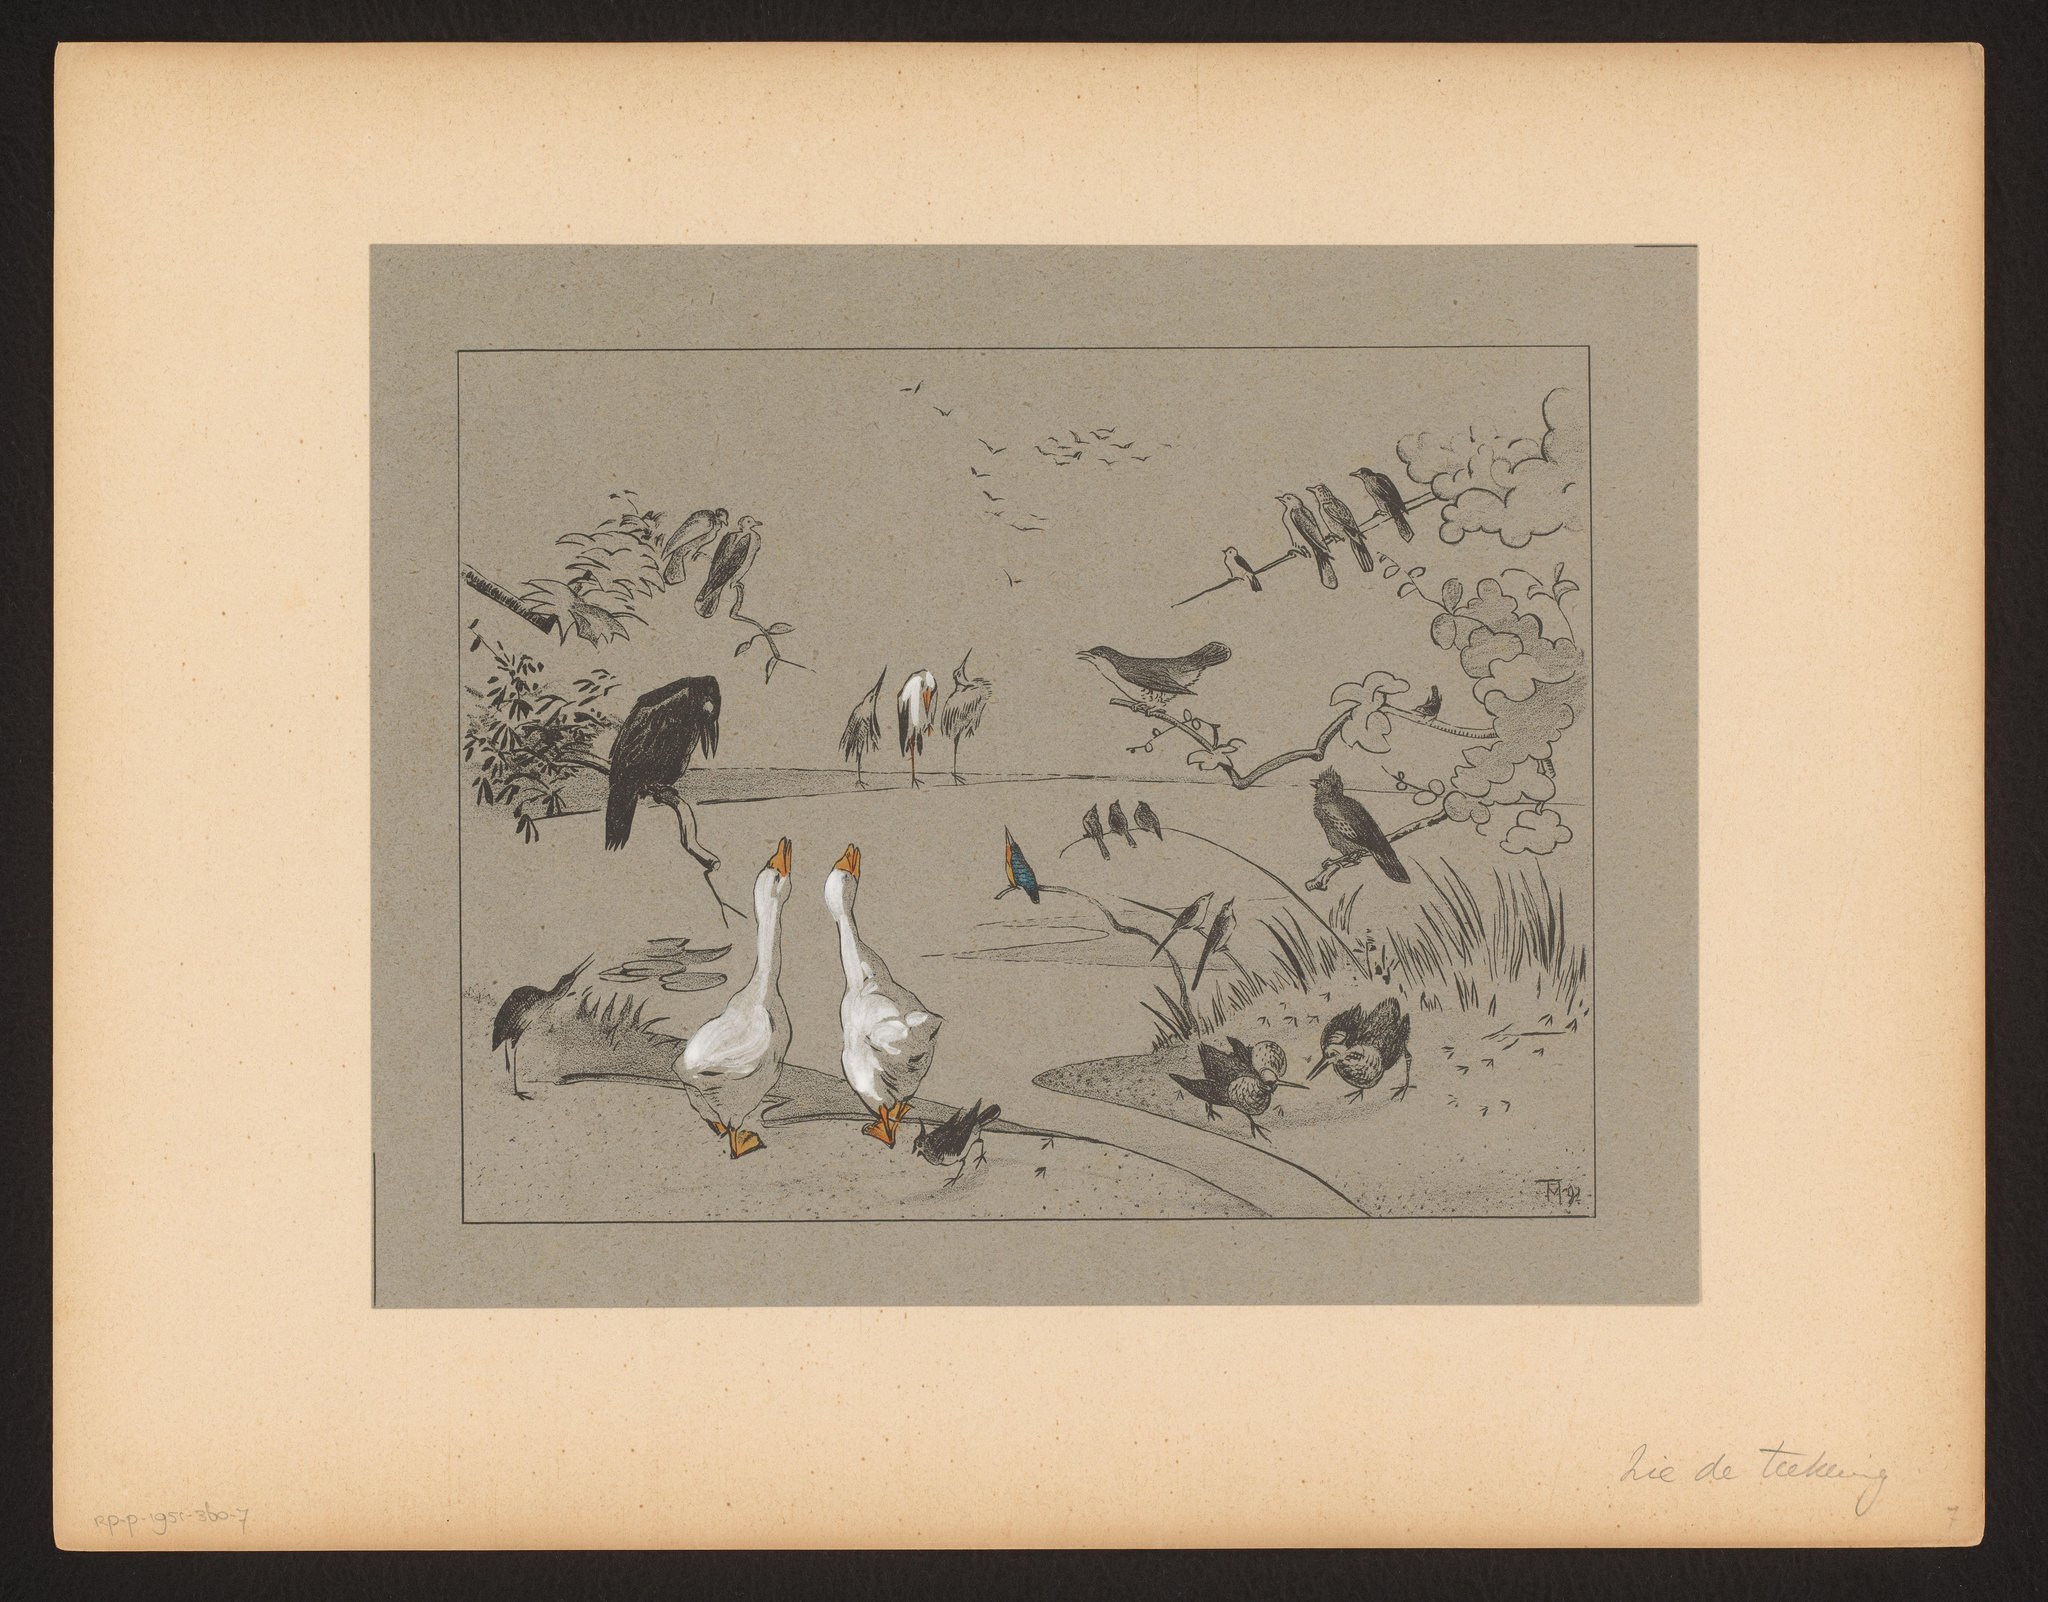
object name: print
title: Hoe de vogels aan een koning kwamen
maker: theo van hoytema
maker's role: draughtsman, painter, print maker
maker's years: 1863-1917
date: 1892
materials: paper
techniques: hand coloring, lithograph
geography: the hague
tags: water-birds: goose, shore-birds and wading-birds: stork, song-birds: crow, song-birds: wren, shore-birds and wading-birds: lapwing, other birds: kingfisher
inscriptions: annotation: ‘Zie de teekening’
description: Onder andere een kraai, twee ganzen, een ijsvogel, kievit, twee kemphanen, een koekoek en een winterkoninkje.